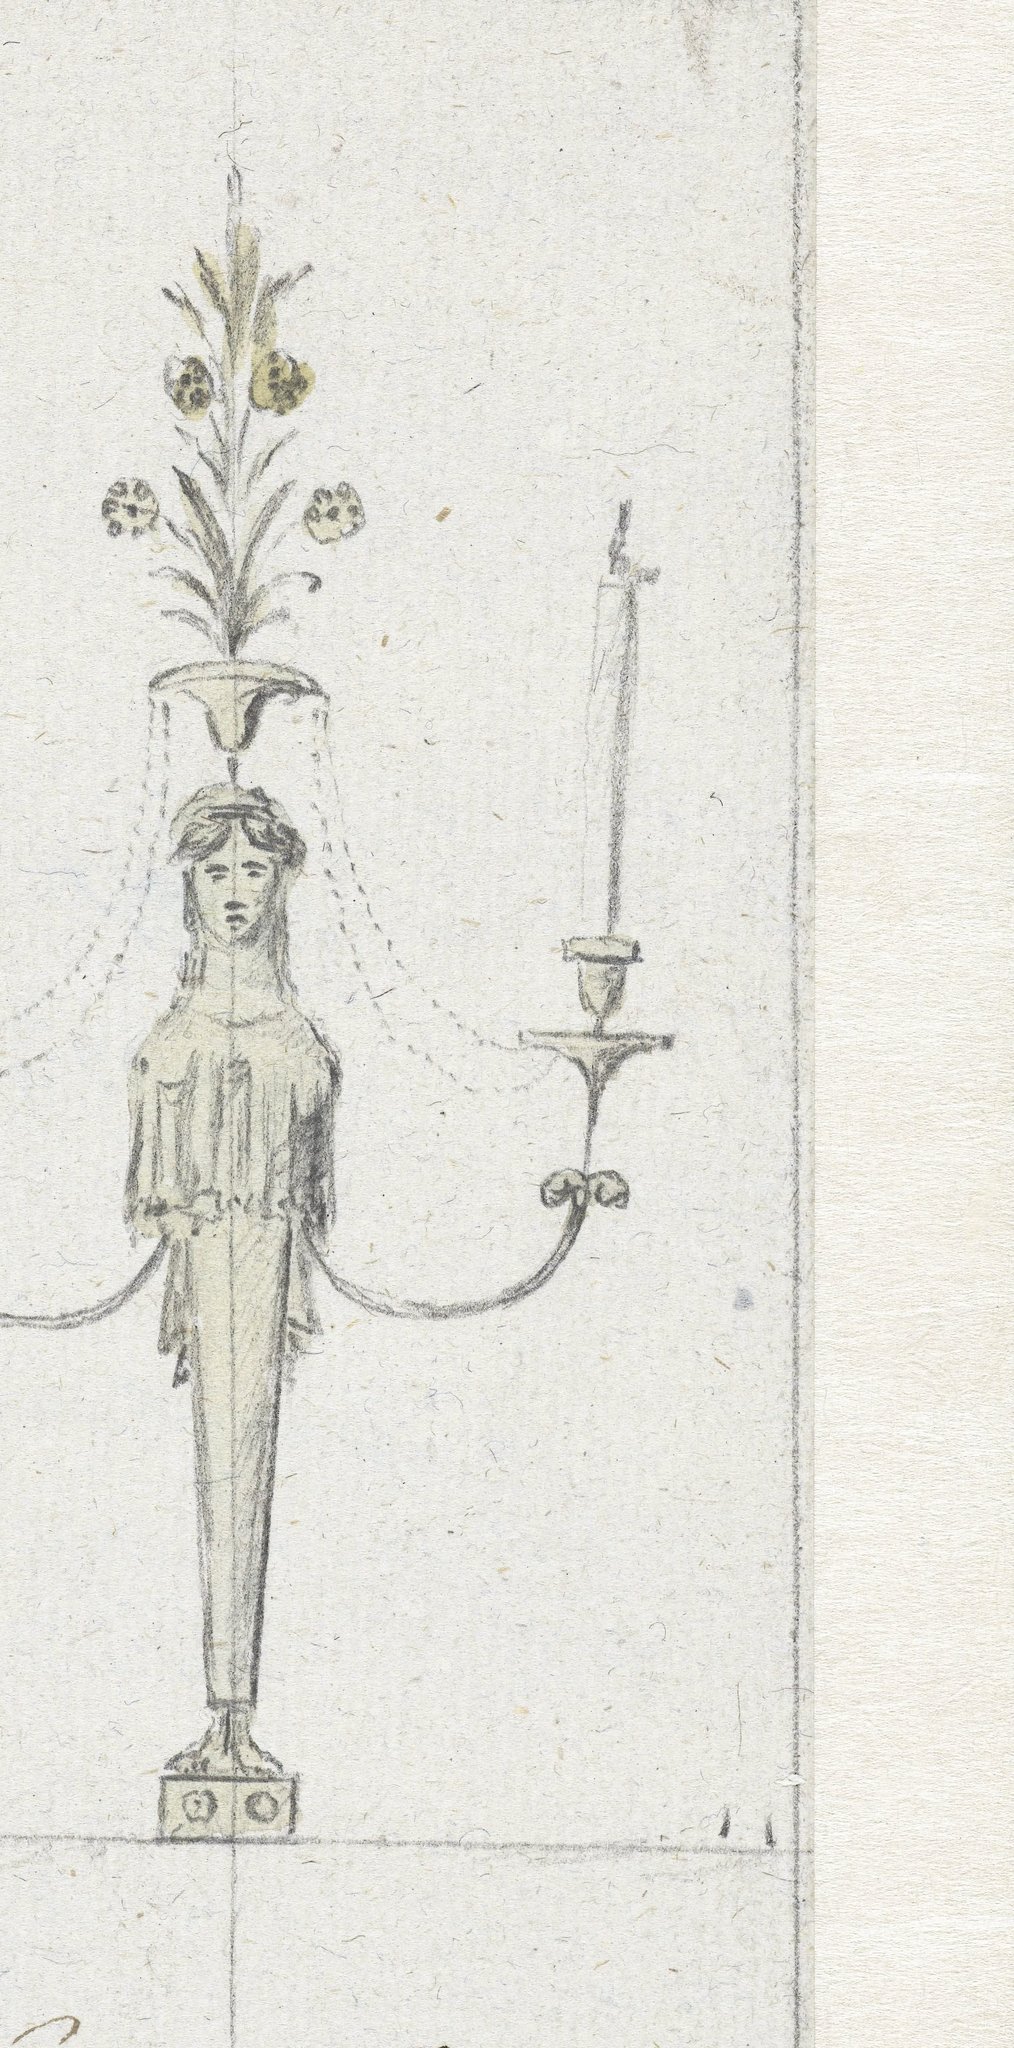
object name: design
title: Ontwerp voor een kandelaar (No. 11)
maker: abraham meertens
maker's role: draughtsman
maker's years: 1757-1823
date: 1767-1823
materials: paper, pencil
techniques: brush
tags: sconce, wall lamp